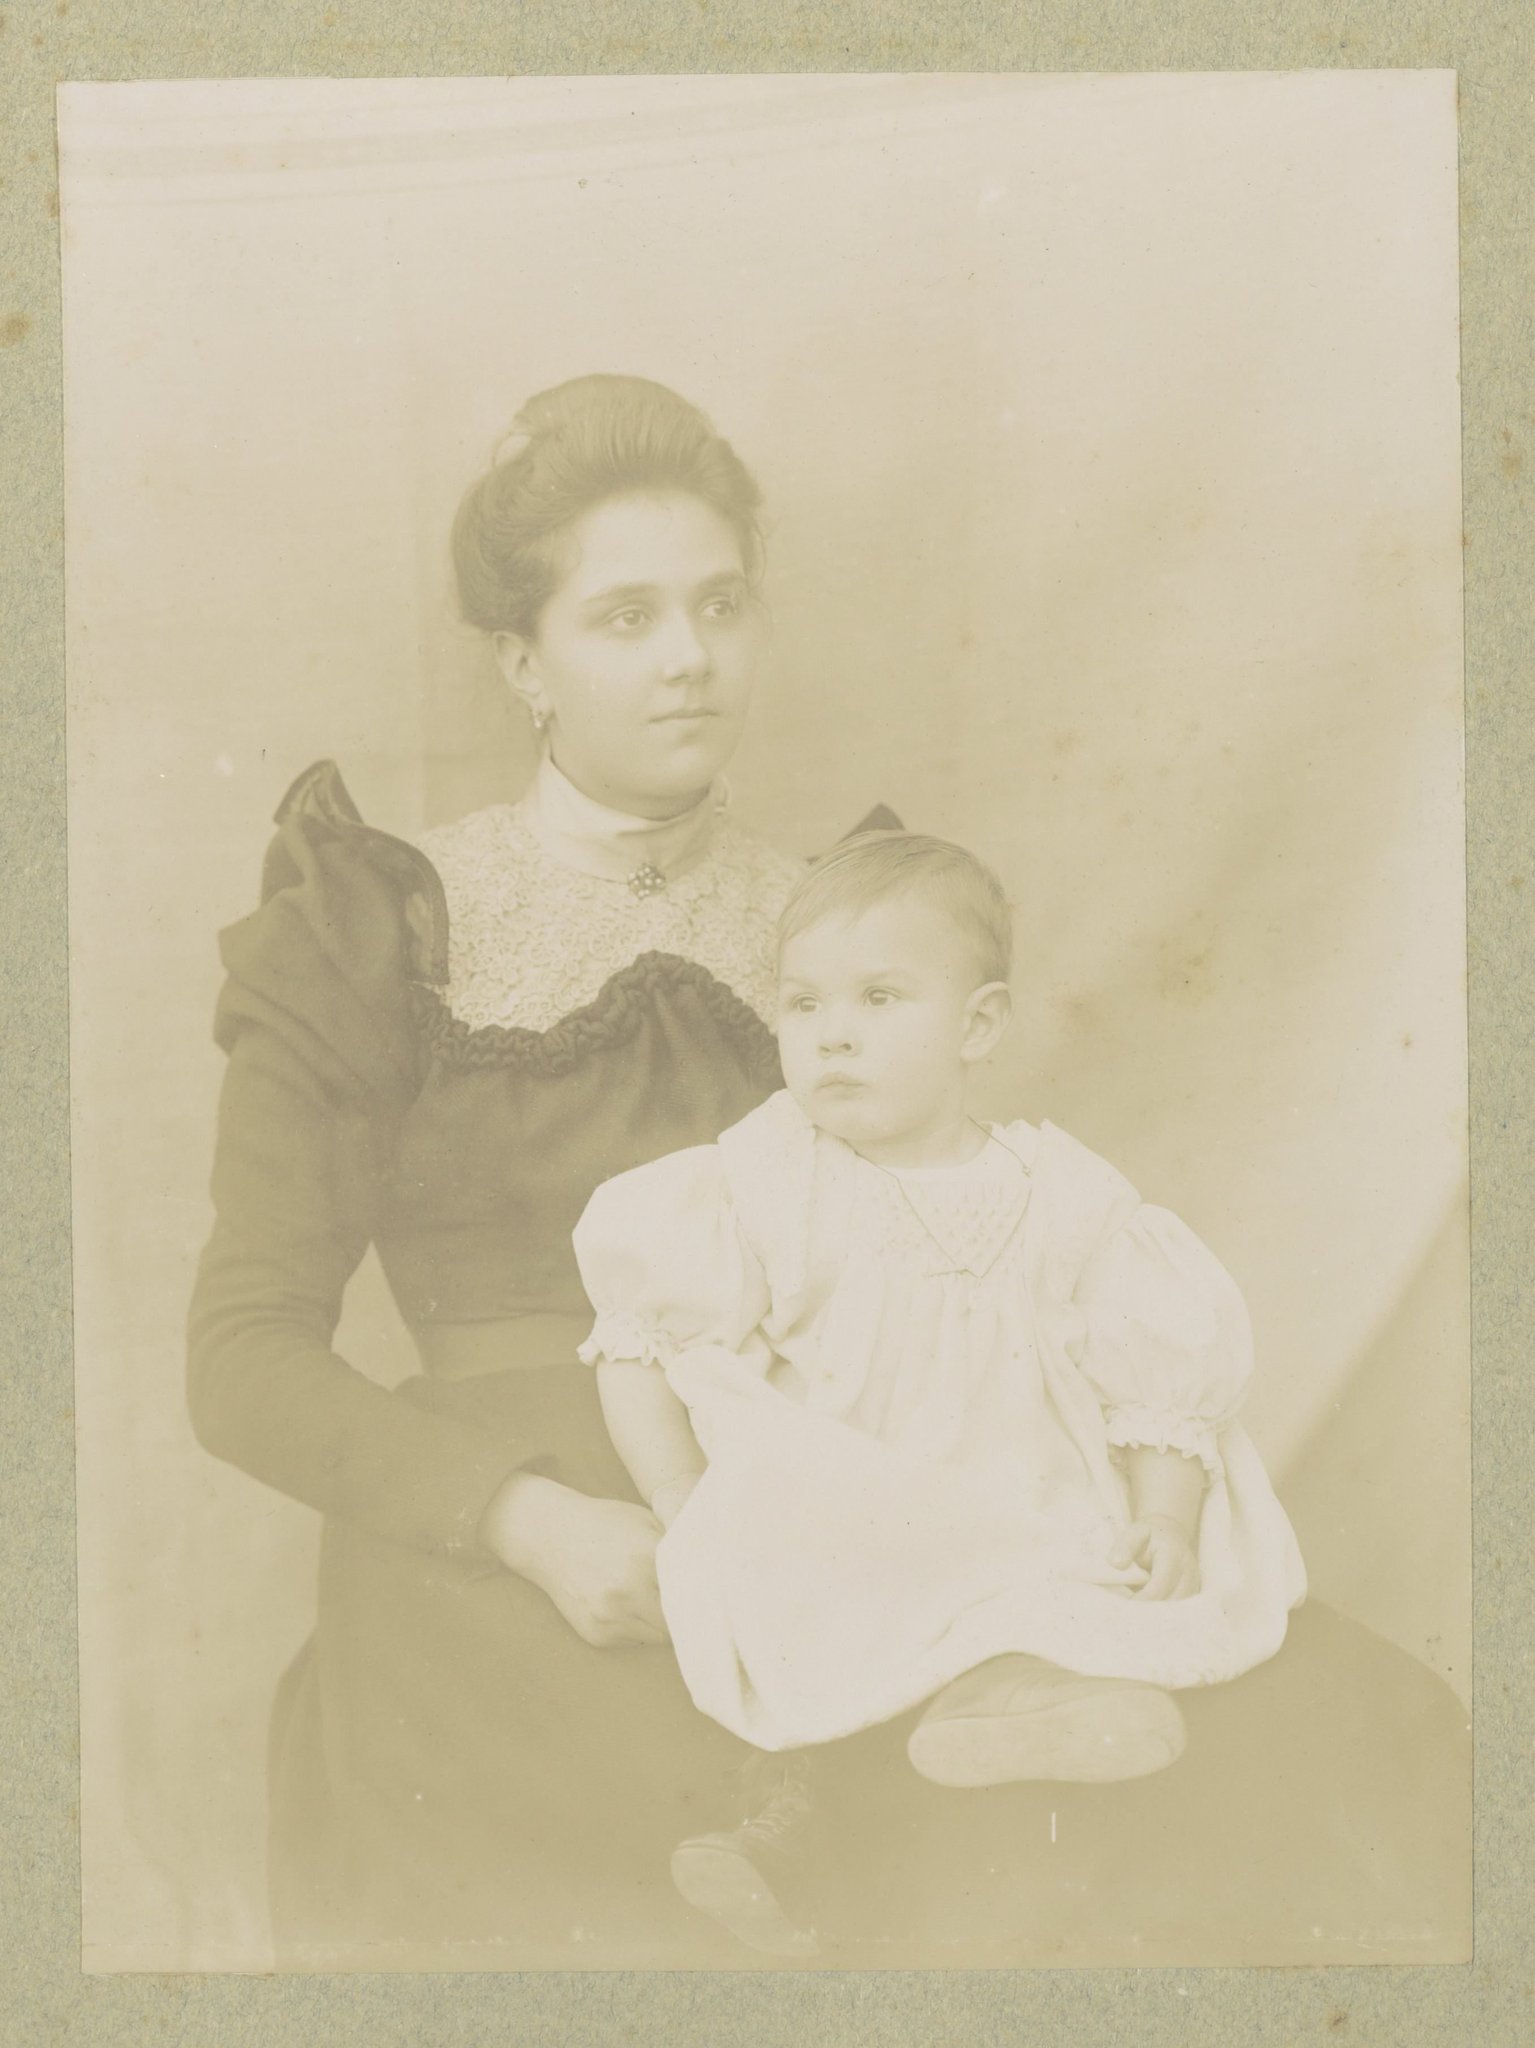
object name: photograph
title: Portret van een vrouw met een baby op schoot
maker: Anonymous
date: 1885-1914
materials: photographic support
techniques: gelatin silver print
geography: france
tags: mother and child(ren), woman and child(ren) (family group), france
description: Onderdeel van Fotoalbum met familiefoto's.